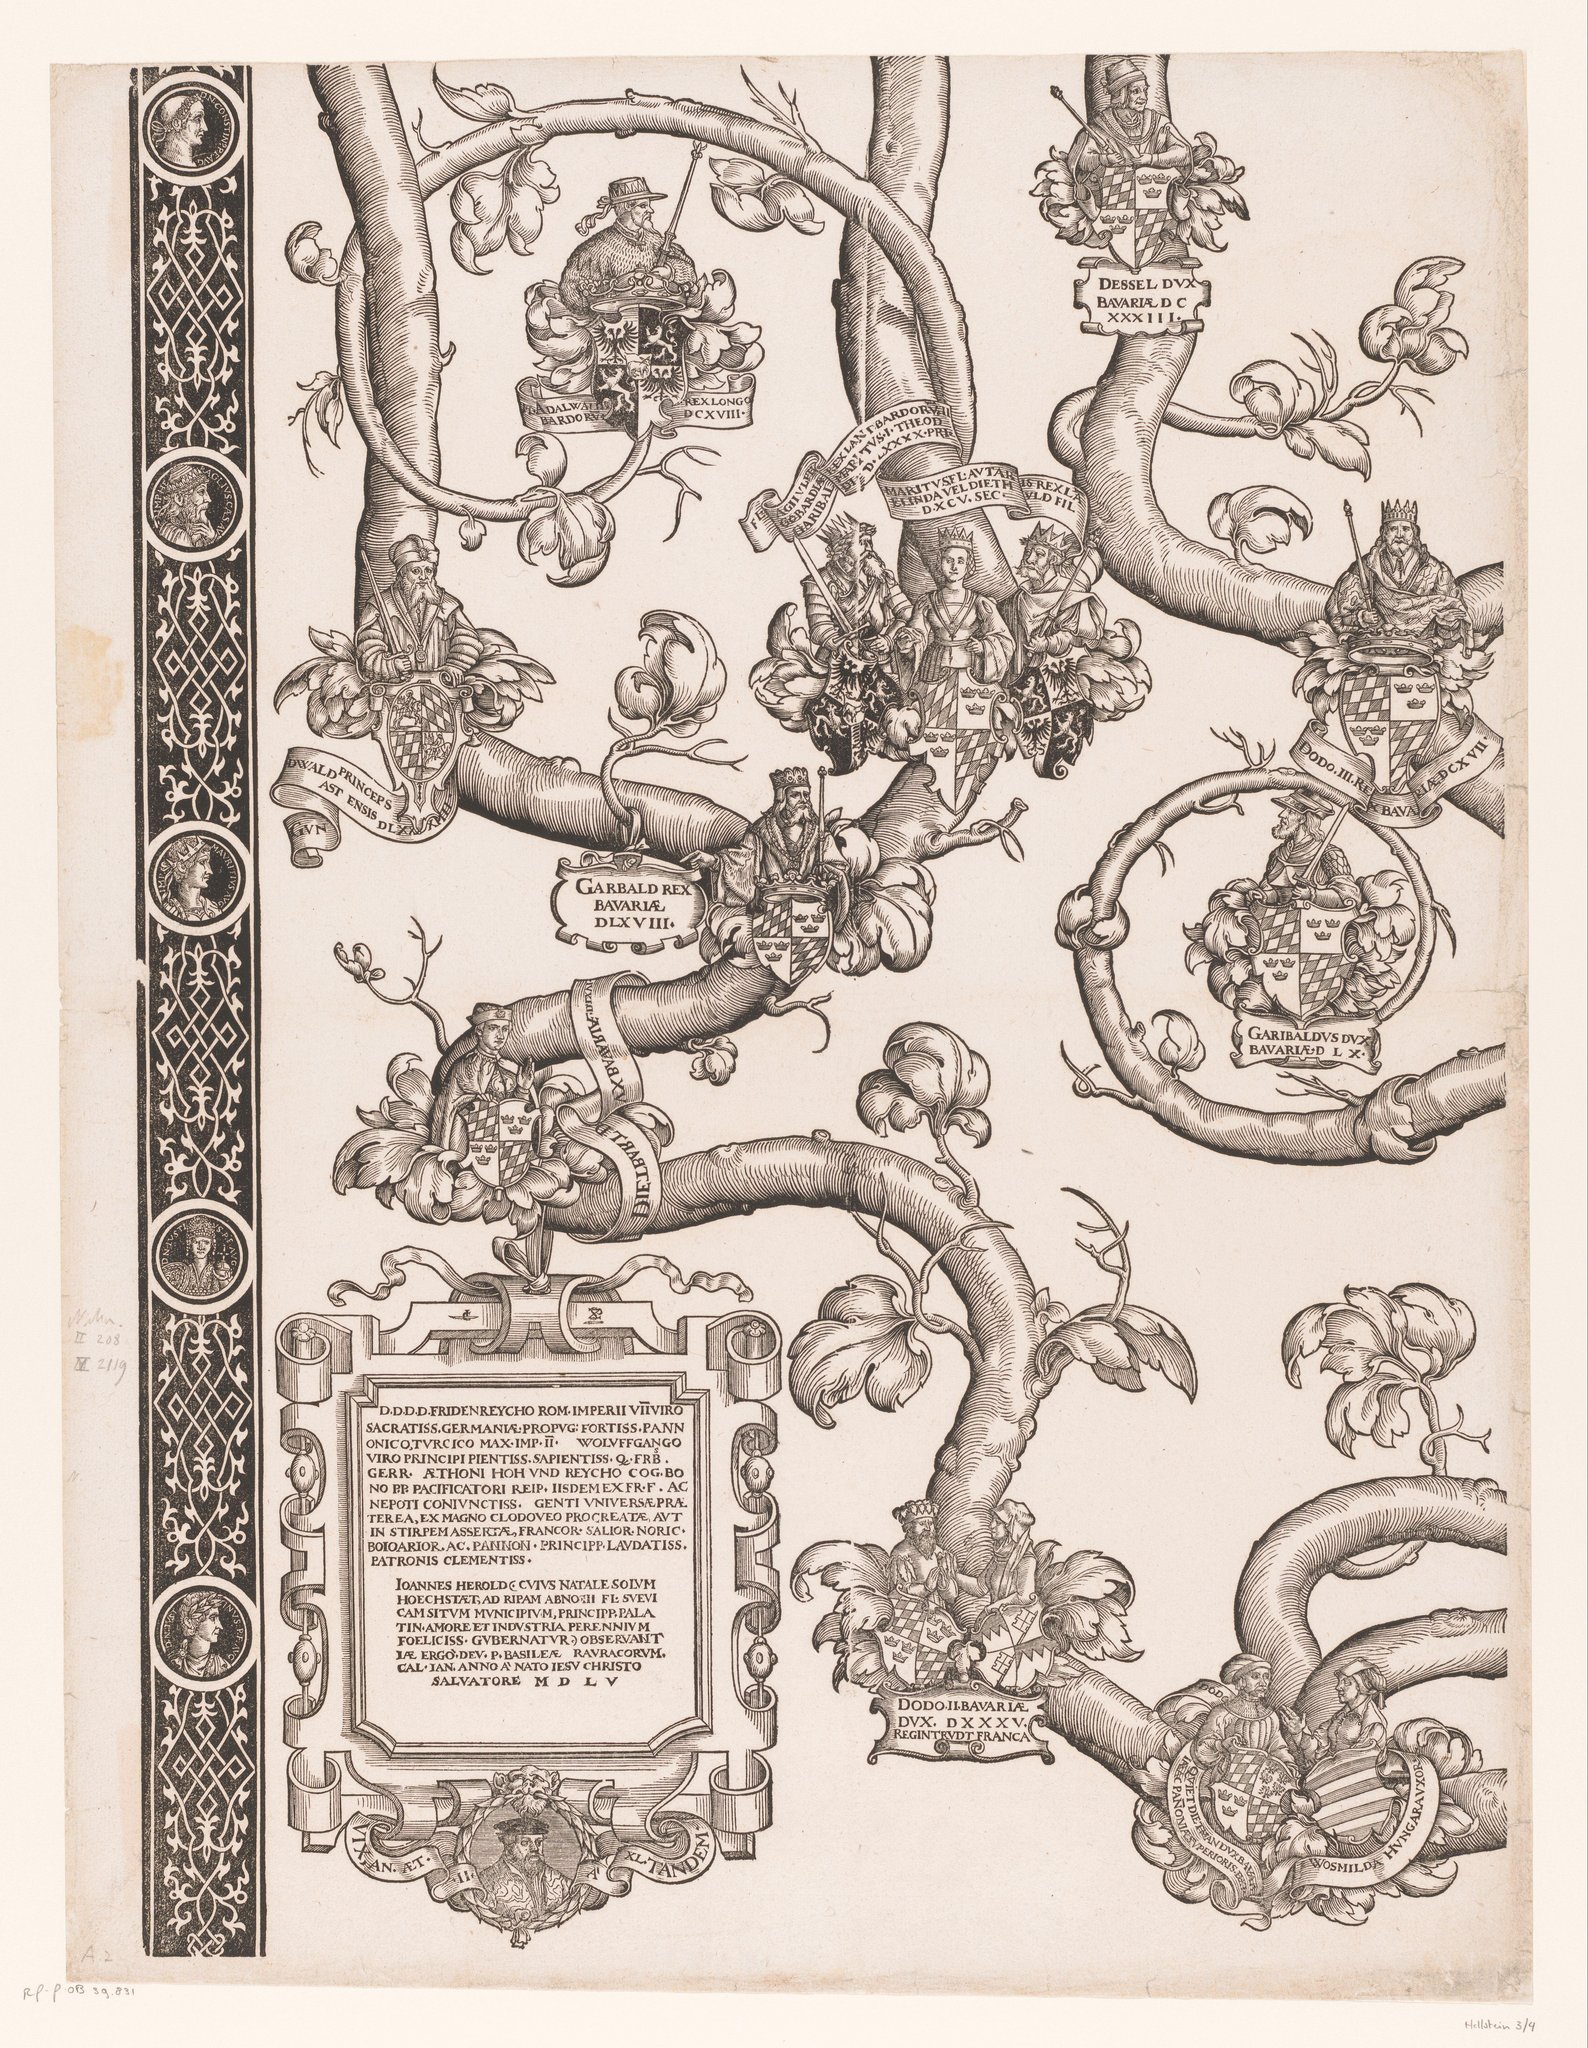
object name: print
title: Stamboom van Frederik en Ottheinrich van Palts-Neuburg (plaat 4)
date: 1535-1594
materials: paper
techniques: letterpress printing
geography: basel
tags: amberg, earl, family lineage, pedigree, genealogical tree or table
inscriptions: collector's mark: Lugt 240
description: Blad 4 van een stamboom bestaande uit 21 bladen, gedrukt van 42 blokken.